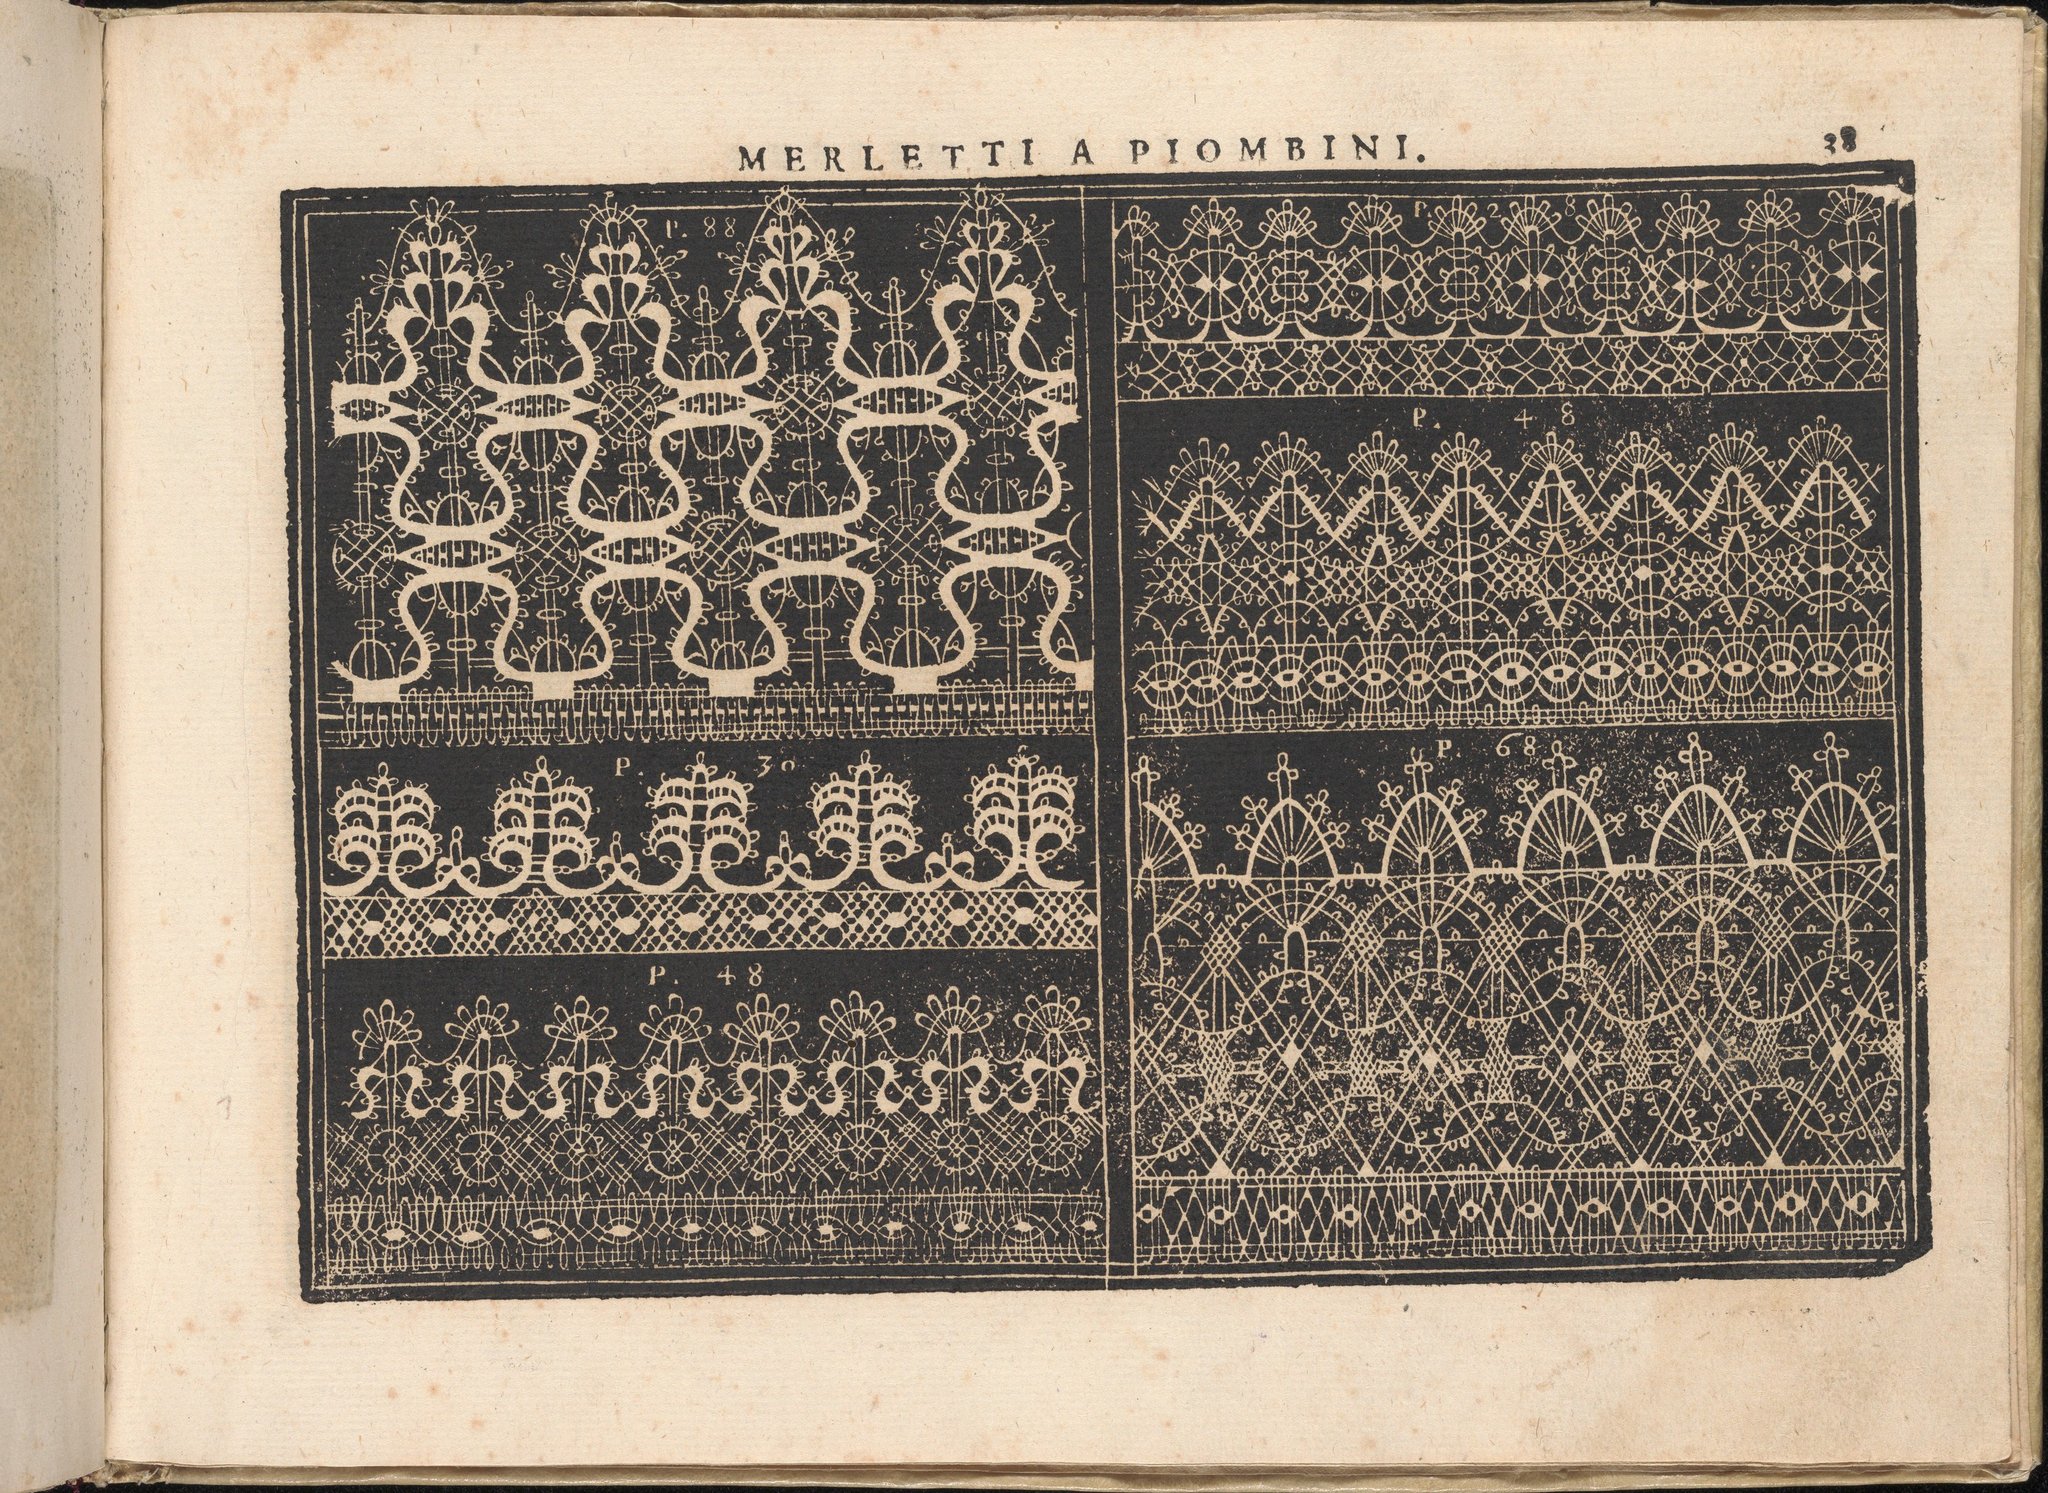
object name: book print ornament architecture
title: Fiore D'Ogni Virtu Per le Nobili Et Honeste Matrone, page 38 (recto)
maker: isabella catanea parasole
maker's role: designer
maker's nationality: italian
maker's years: 1565-1625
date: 1610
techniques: woodcut